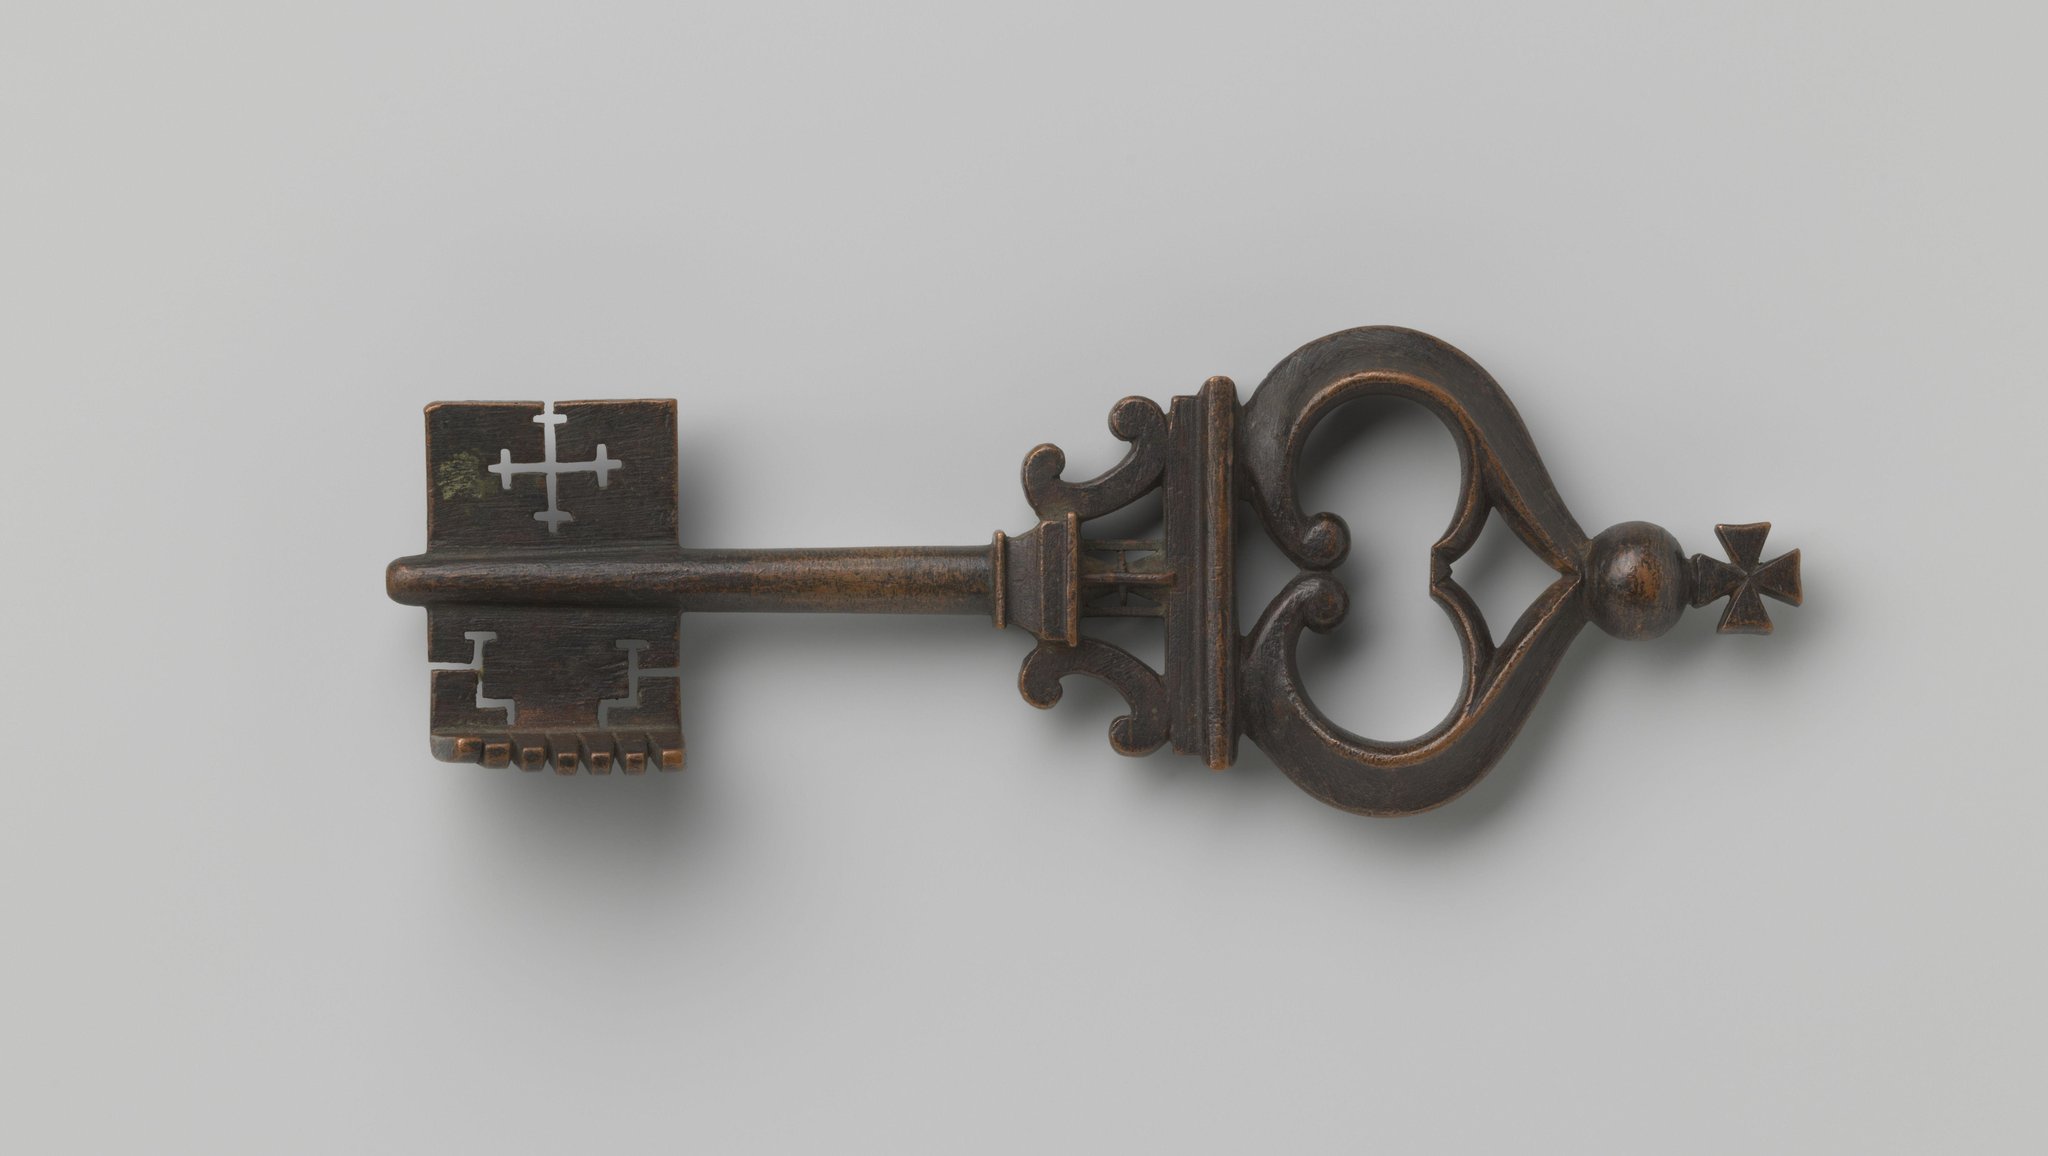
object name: ceremoniesleutel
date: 1800-1900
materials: bronze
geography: russia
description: Ceremoniesleutel met dubbele baard waarvan een baard rechthoekig hierop geplaatste tanden heeft. De greep, die op een vierkant kapiteel rust, wordt gevormd uit twee afgewende C-voluten, een zandloper insluitend. Zij schragen een architraaf waarop weer twee naar elkaar toegewende C-voluten geplaatst zijn die bekroond worden door een aardbol met kruis.